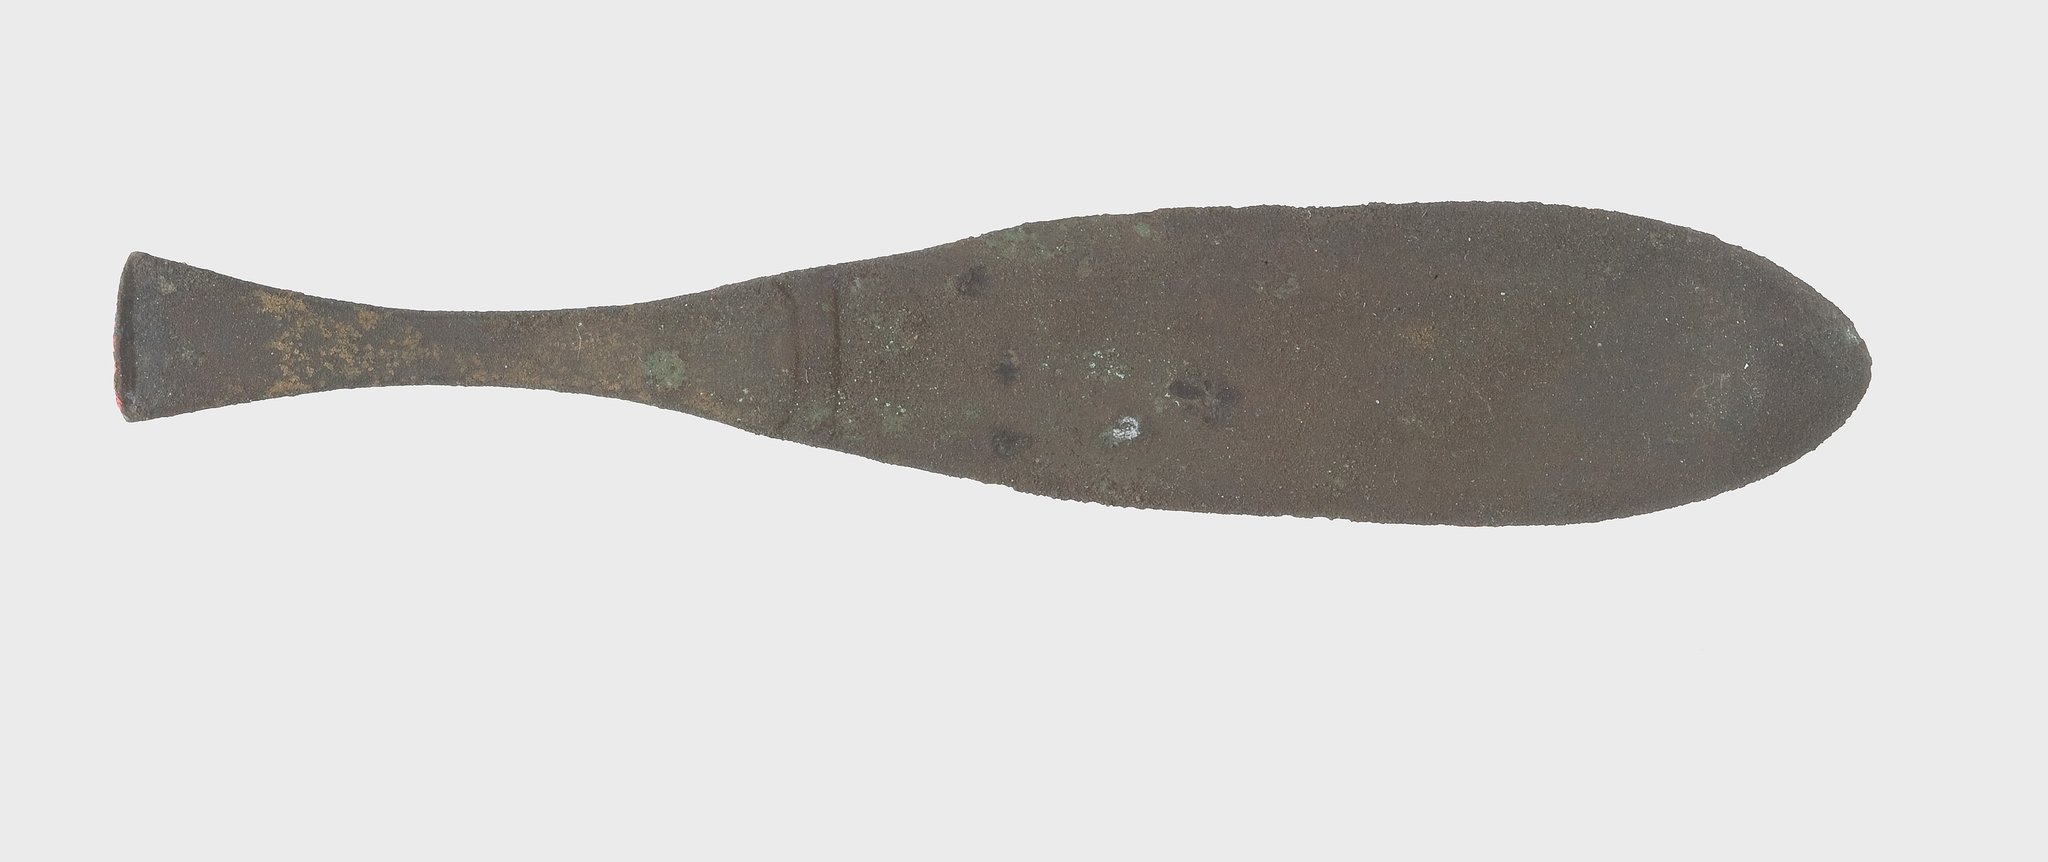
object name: knife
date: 1390-1352 BCE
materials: bronze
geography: egypt